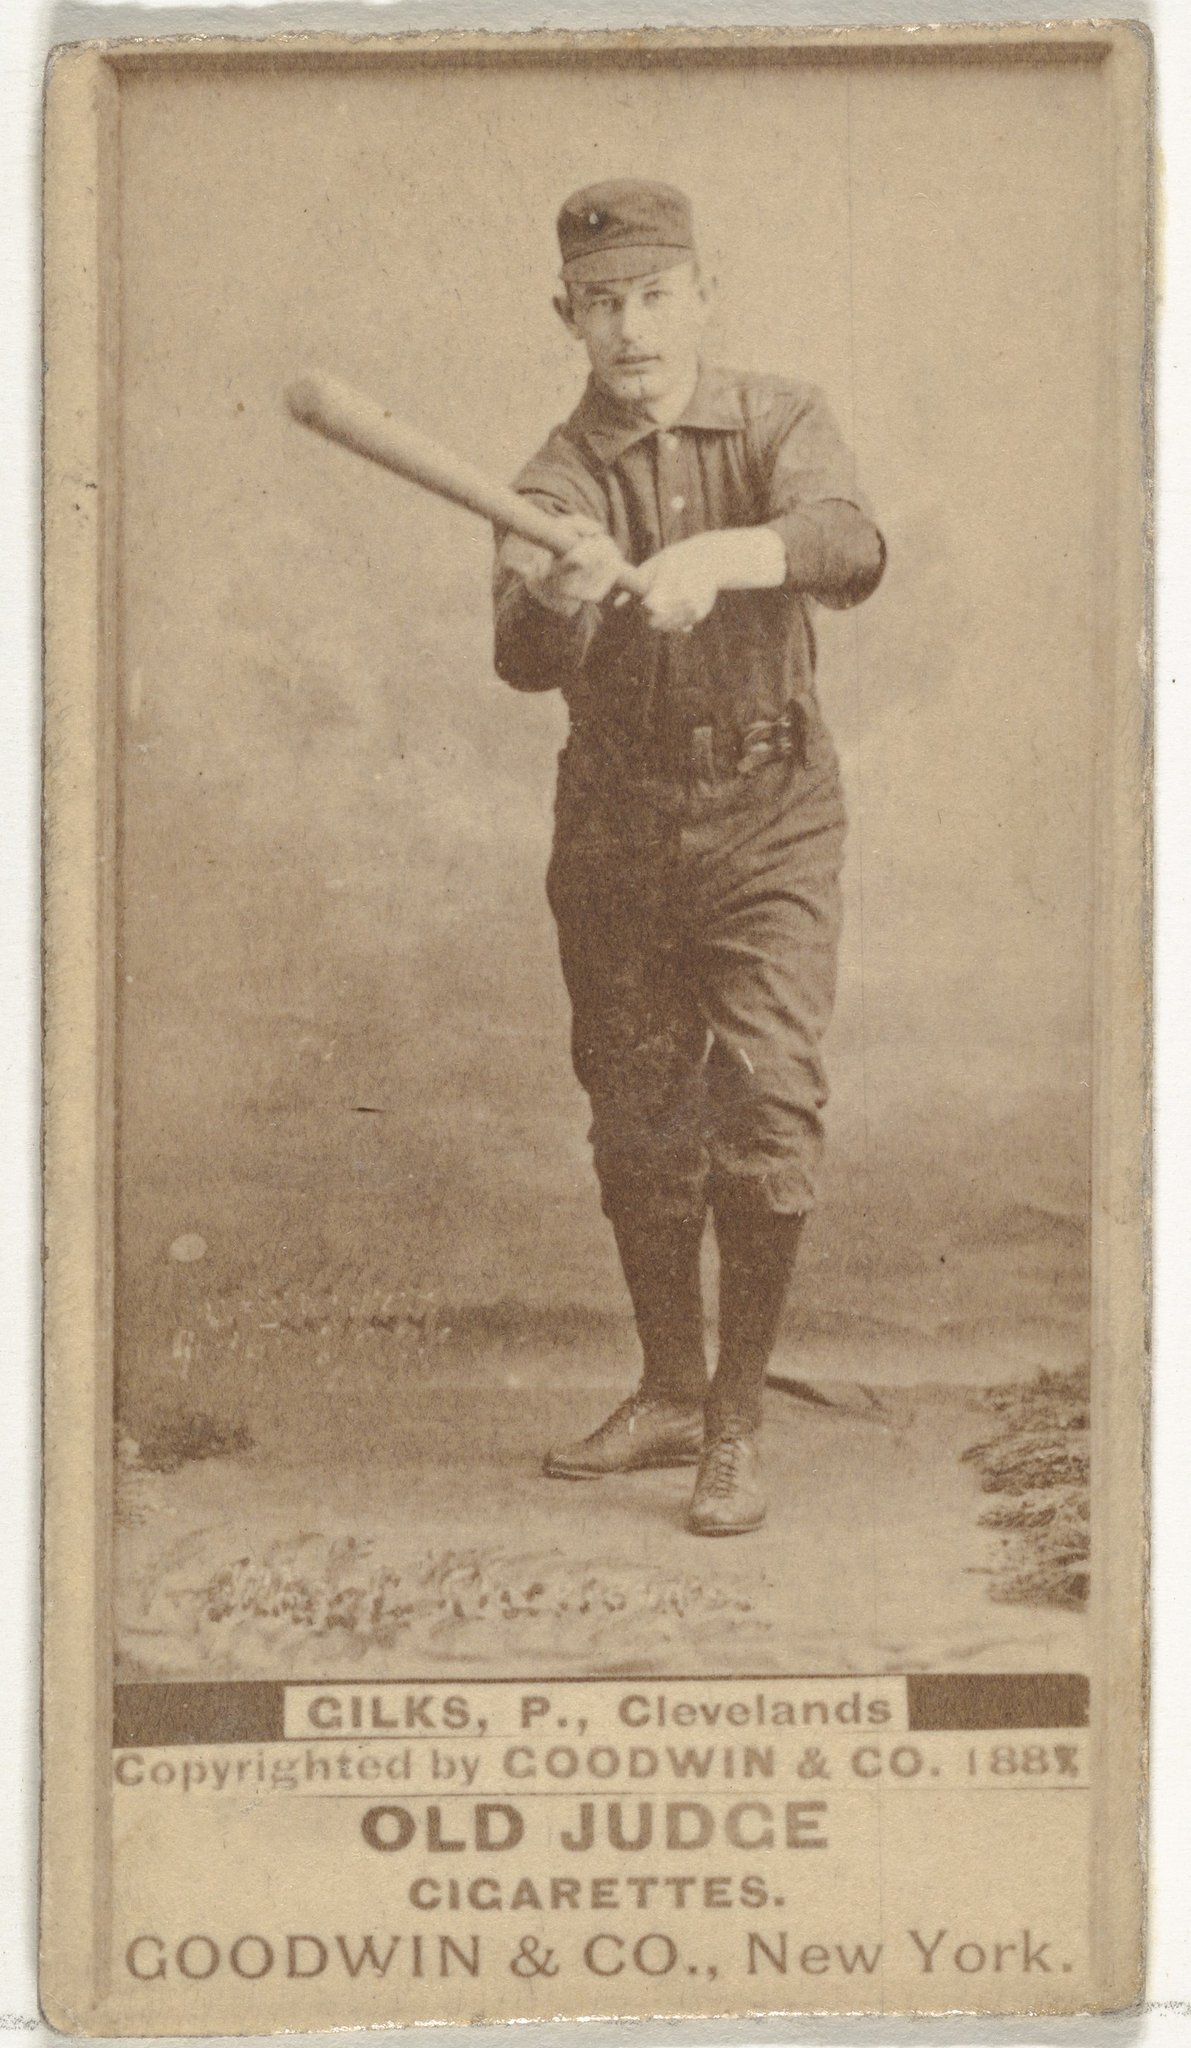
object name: baseball card, photograph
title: Robert James "Bob" Gilks, Pitcher, Cleveland, from the Old Judge series (N172) for Old Judge Cigarettes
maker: goodwin & company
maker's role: publisher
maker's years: 1850-1950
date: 1888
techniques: albumen silver print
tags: men,portraits,baseball,athletes